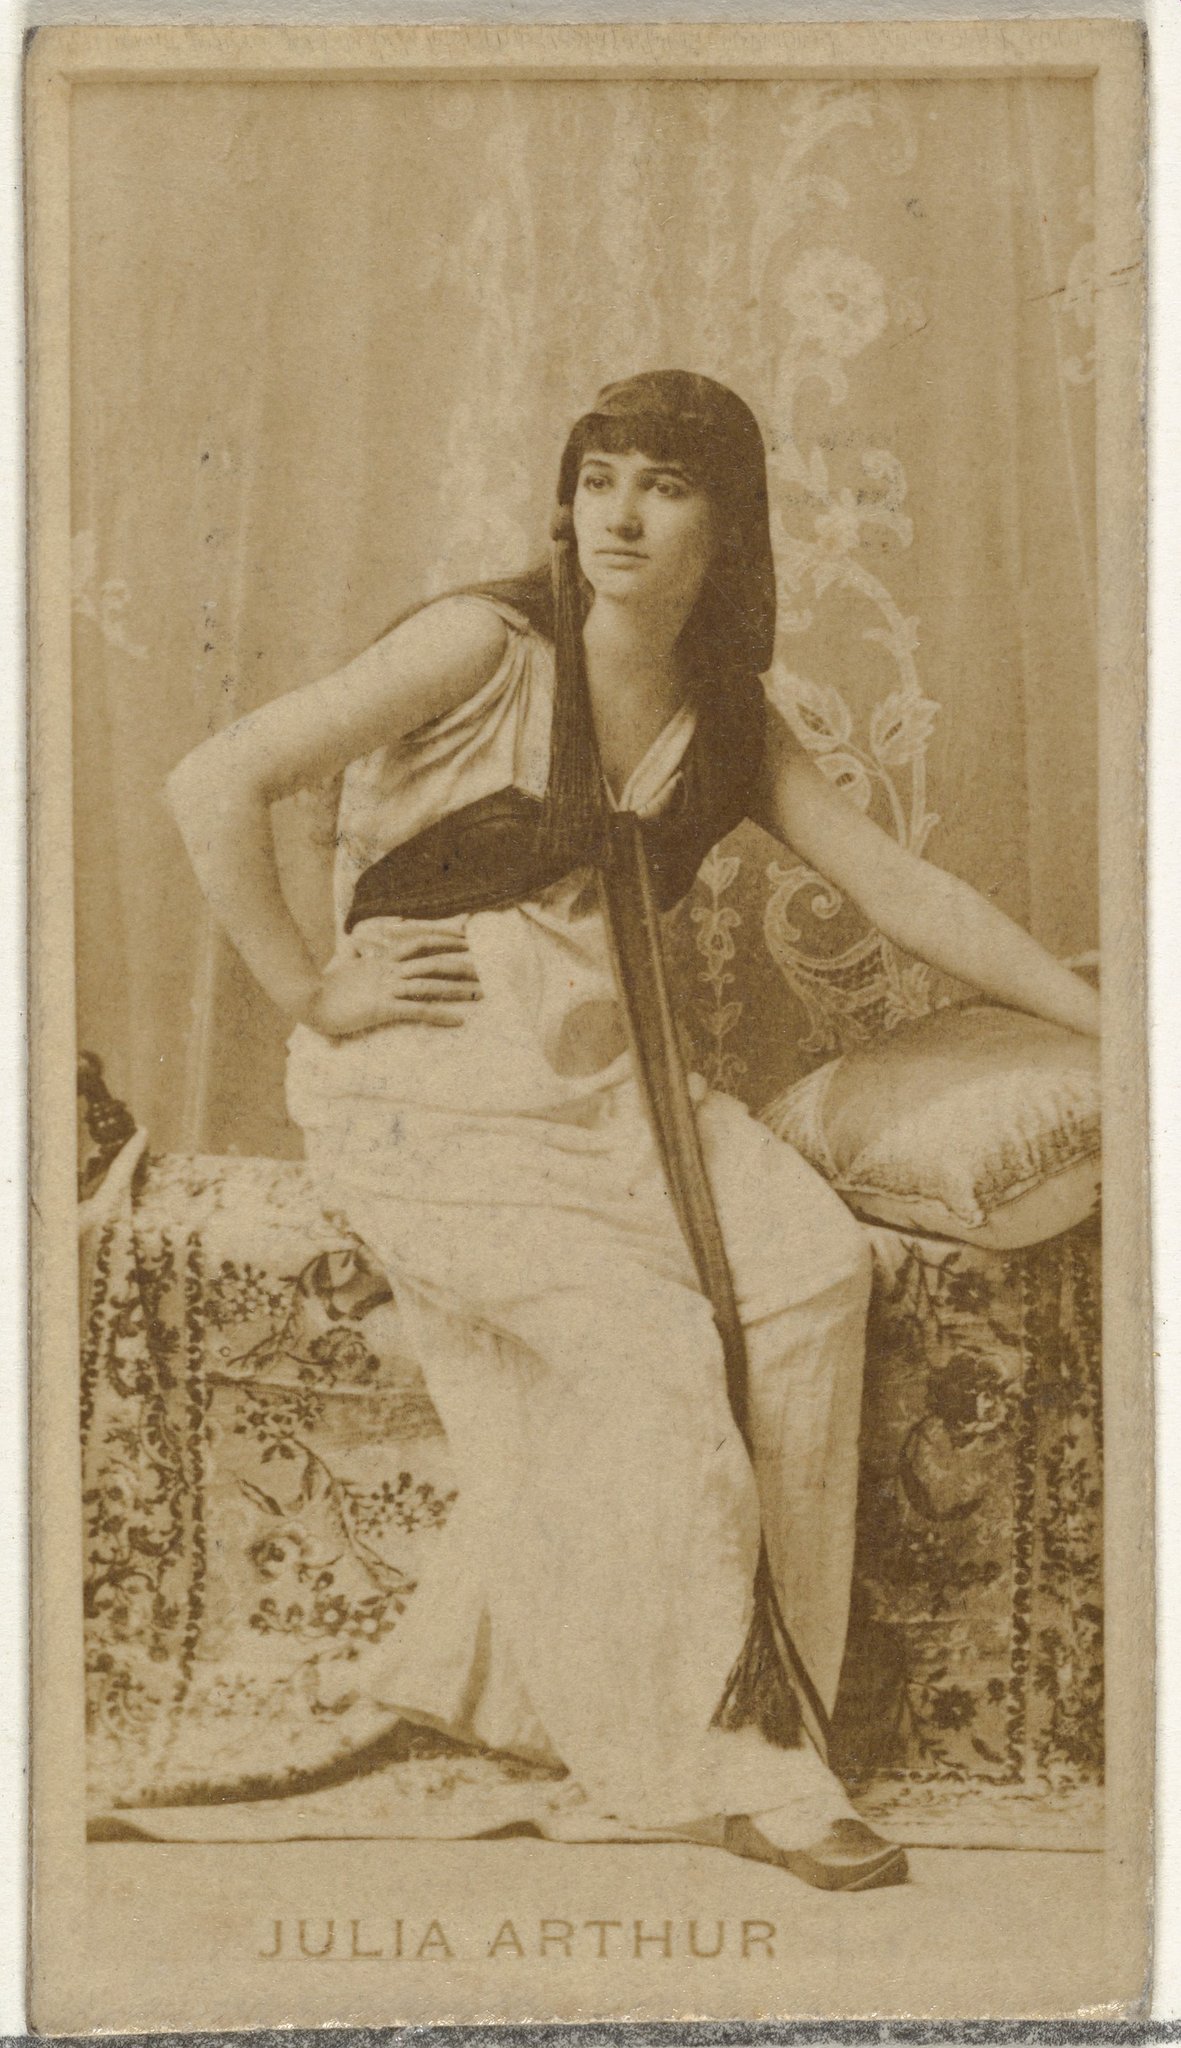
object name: photograph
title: Julia Arthur, from the Actors and Actresses series (N145-8) issued by Duke Sons & Co. to promote Duke Cigarettes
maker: w. duke, sons & co.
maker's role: publisher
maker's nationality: american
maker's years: 1870-1920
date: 1891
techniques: albumen silver print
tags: portraits,women,actresses